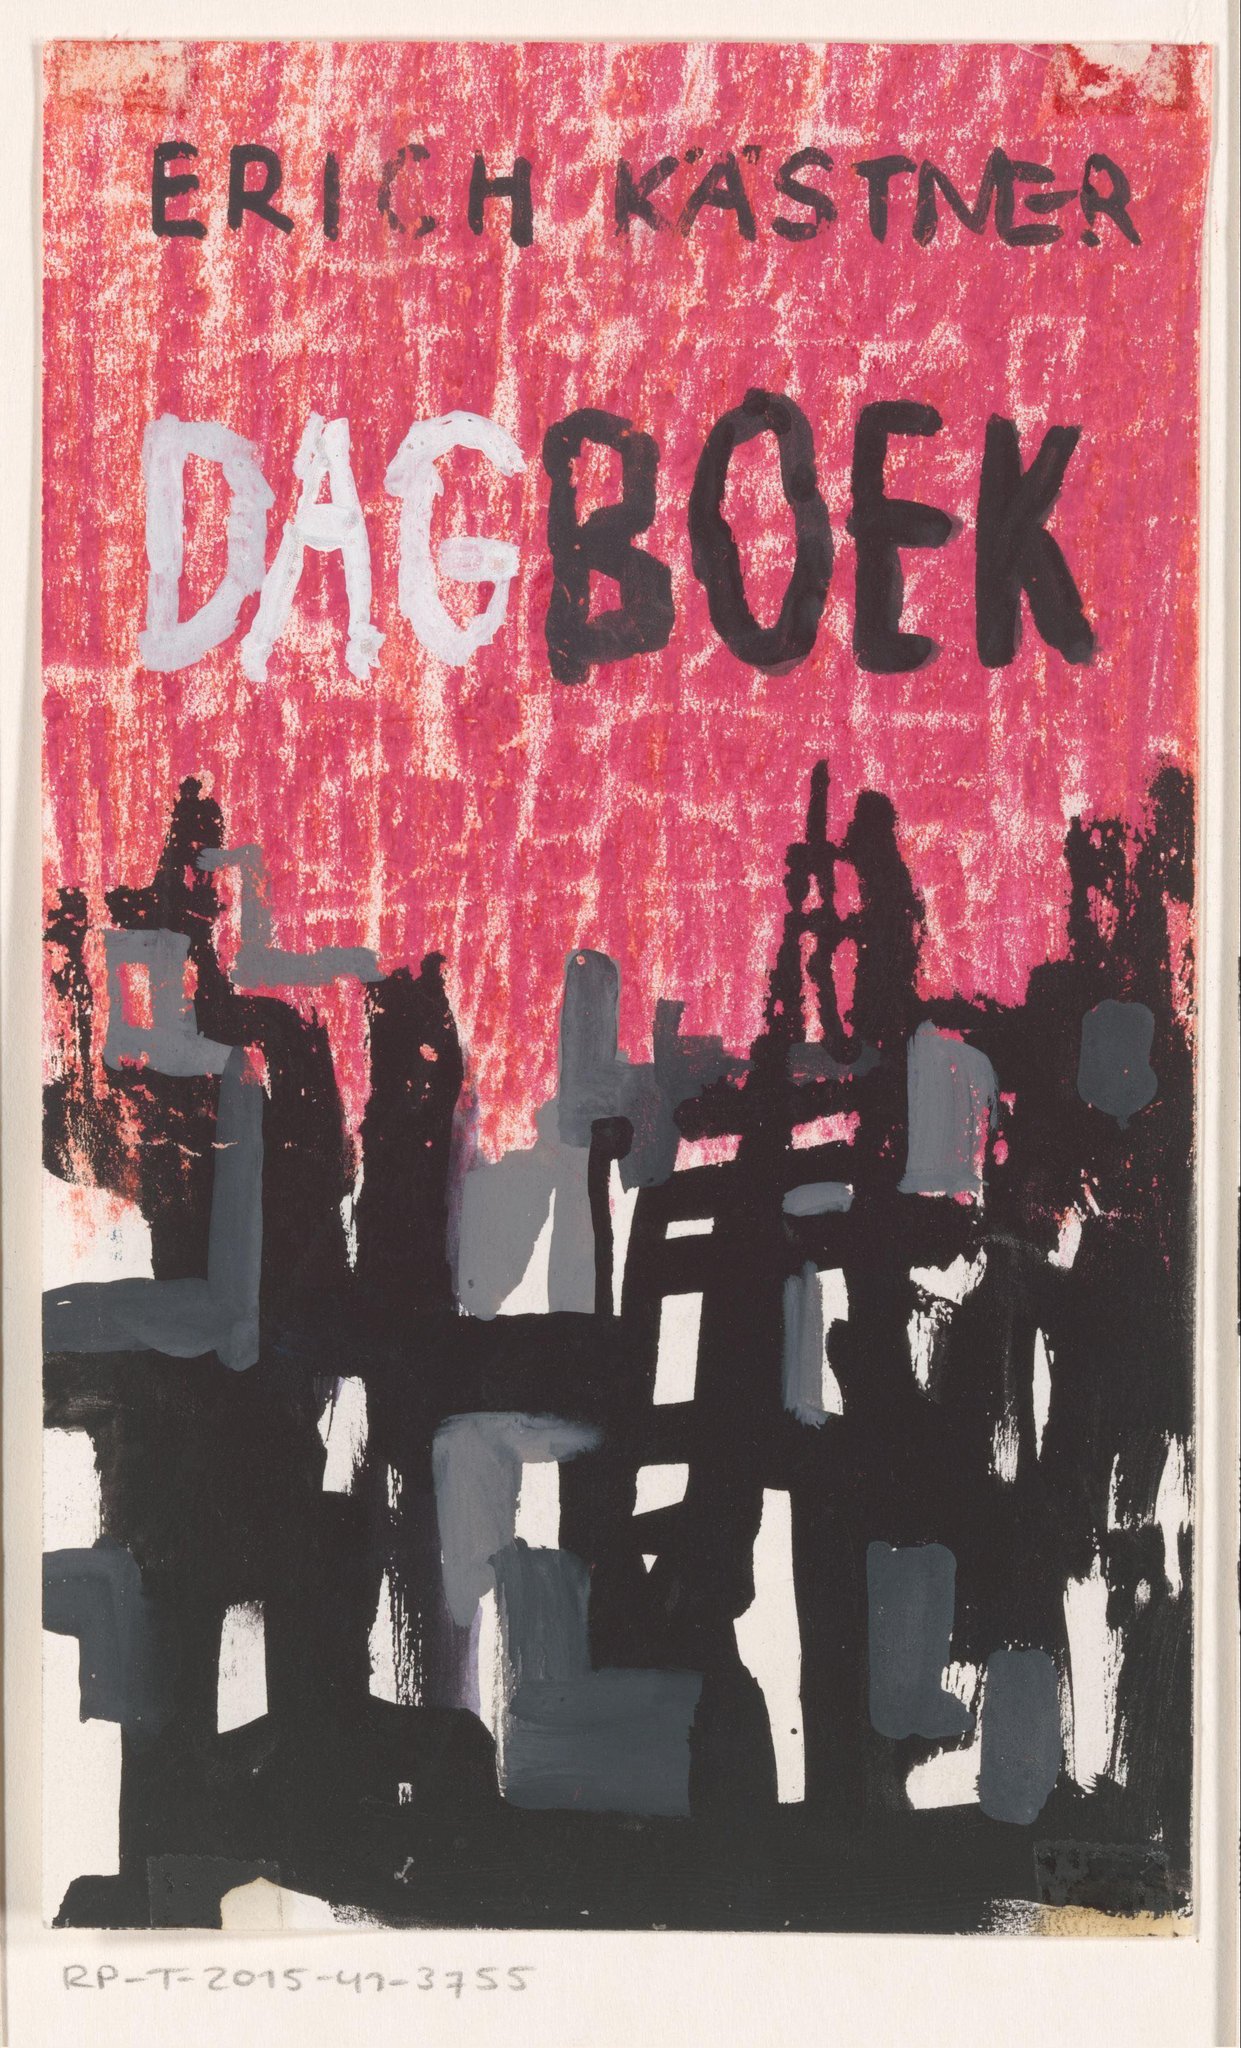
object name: drawing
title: Bandontwerp voor: Erich Kästner, Dagboek. Februari-Augustus 1945 (Notabene 45), 1961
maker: Anonymous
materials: chalk, paint, paper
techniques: brush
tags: prospect of city, town panorama, silhouette of city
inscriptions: collector's mark: Lugt 2228a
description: Silhouetten van gebouwen in een grote stad.